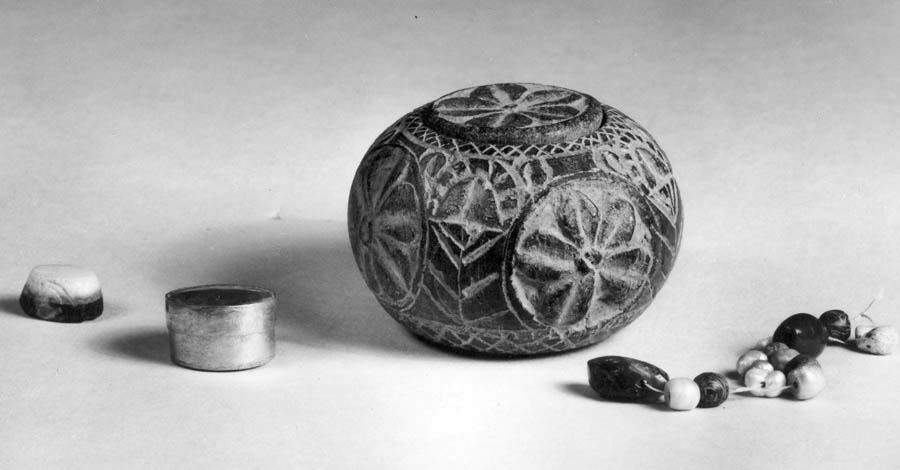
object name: reliquary with content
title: Reliquary with Contents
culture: gandhara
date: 101-300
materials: stone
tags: gandhara